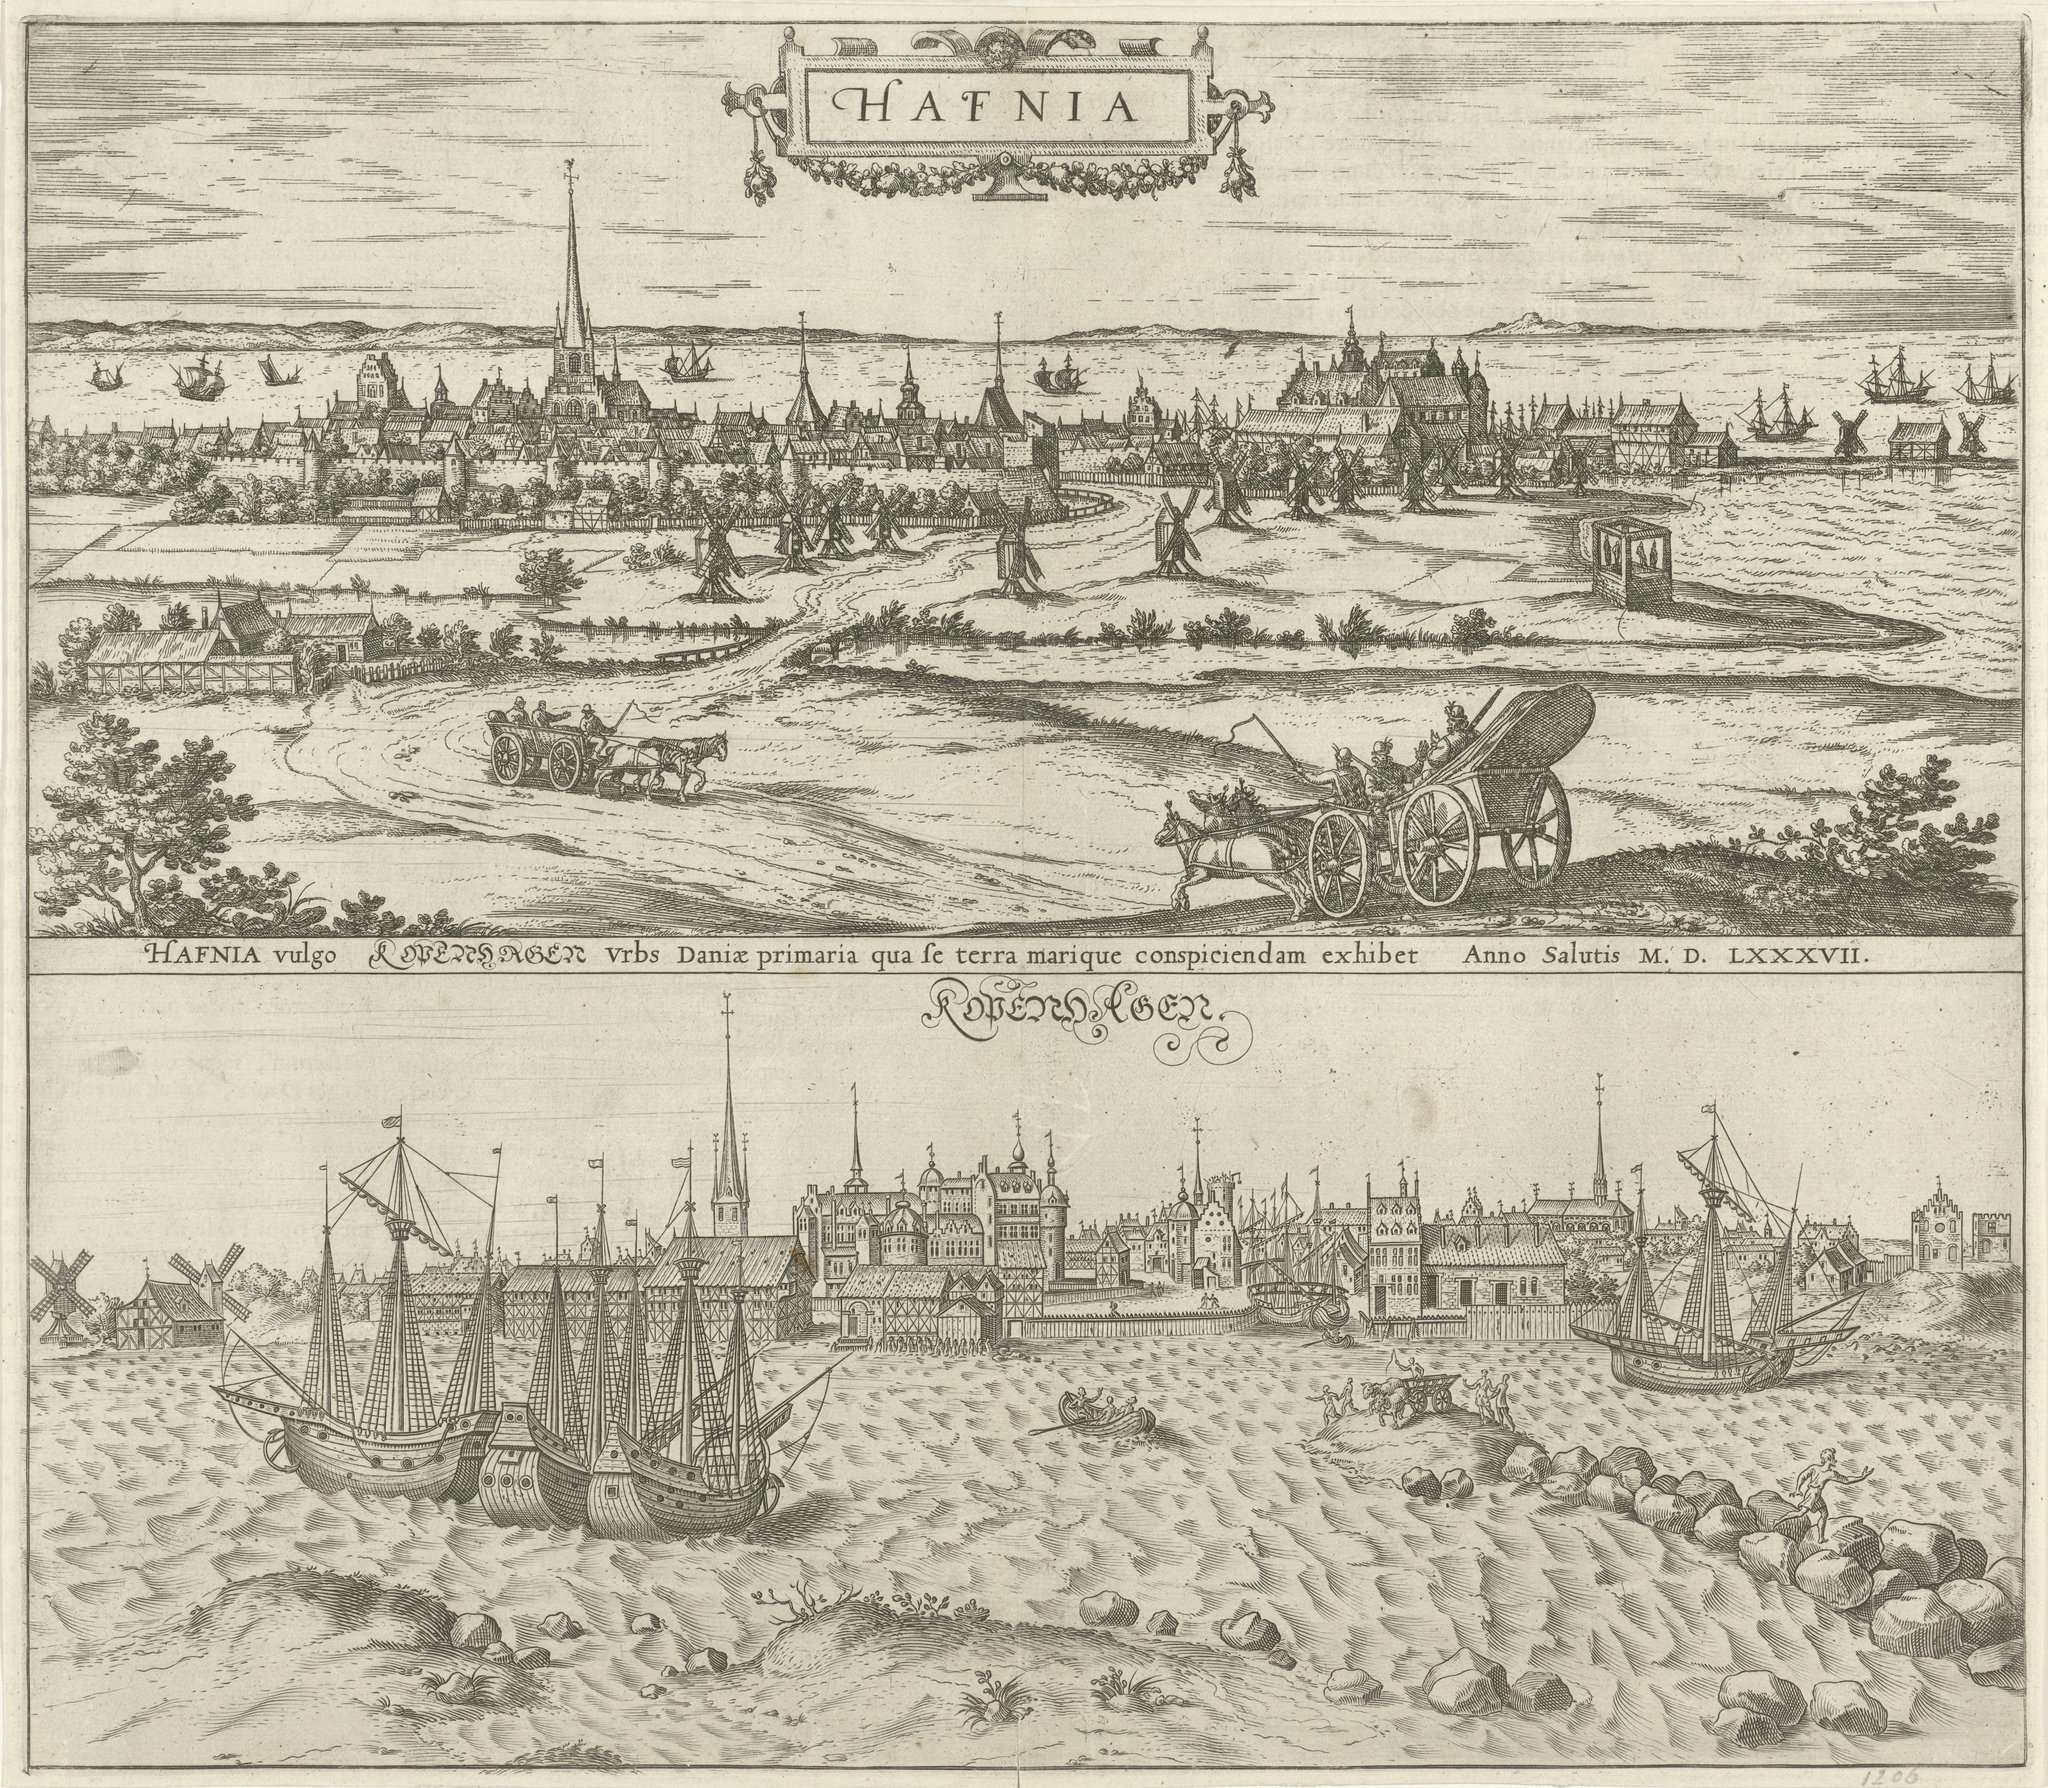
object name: print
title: Hafnia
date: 1588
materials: paper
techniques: etching, letterpress printing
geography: cologne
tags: city-view, and landscape with man-made constructions, copenhagen (city)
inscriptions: collector's mark: Lugt 2228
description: Kaart opgenomen in: Braun, Georg. Civitates orbis terrarum, 6 delen. Keulen: Peter von Brachel en Gottfried von Kempen, 1572-1618, dl. IV (1588).. De door Jan Luyken bewerkte tweede staat werd gebruikt in: Janssonius van Waesberge, Johannes. Tooneel der vermaarste koop-steden en handel-plaatsen van de geheele wereld. Amsterdam: Johannes Janssonius van Waesberge II, 1682.